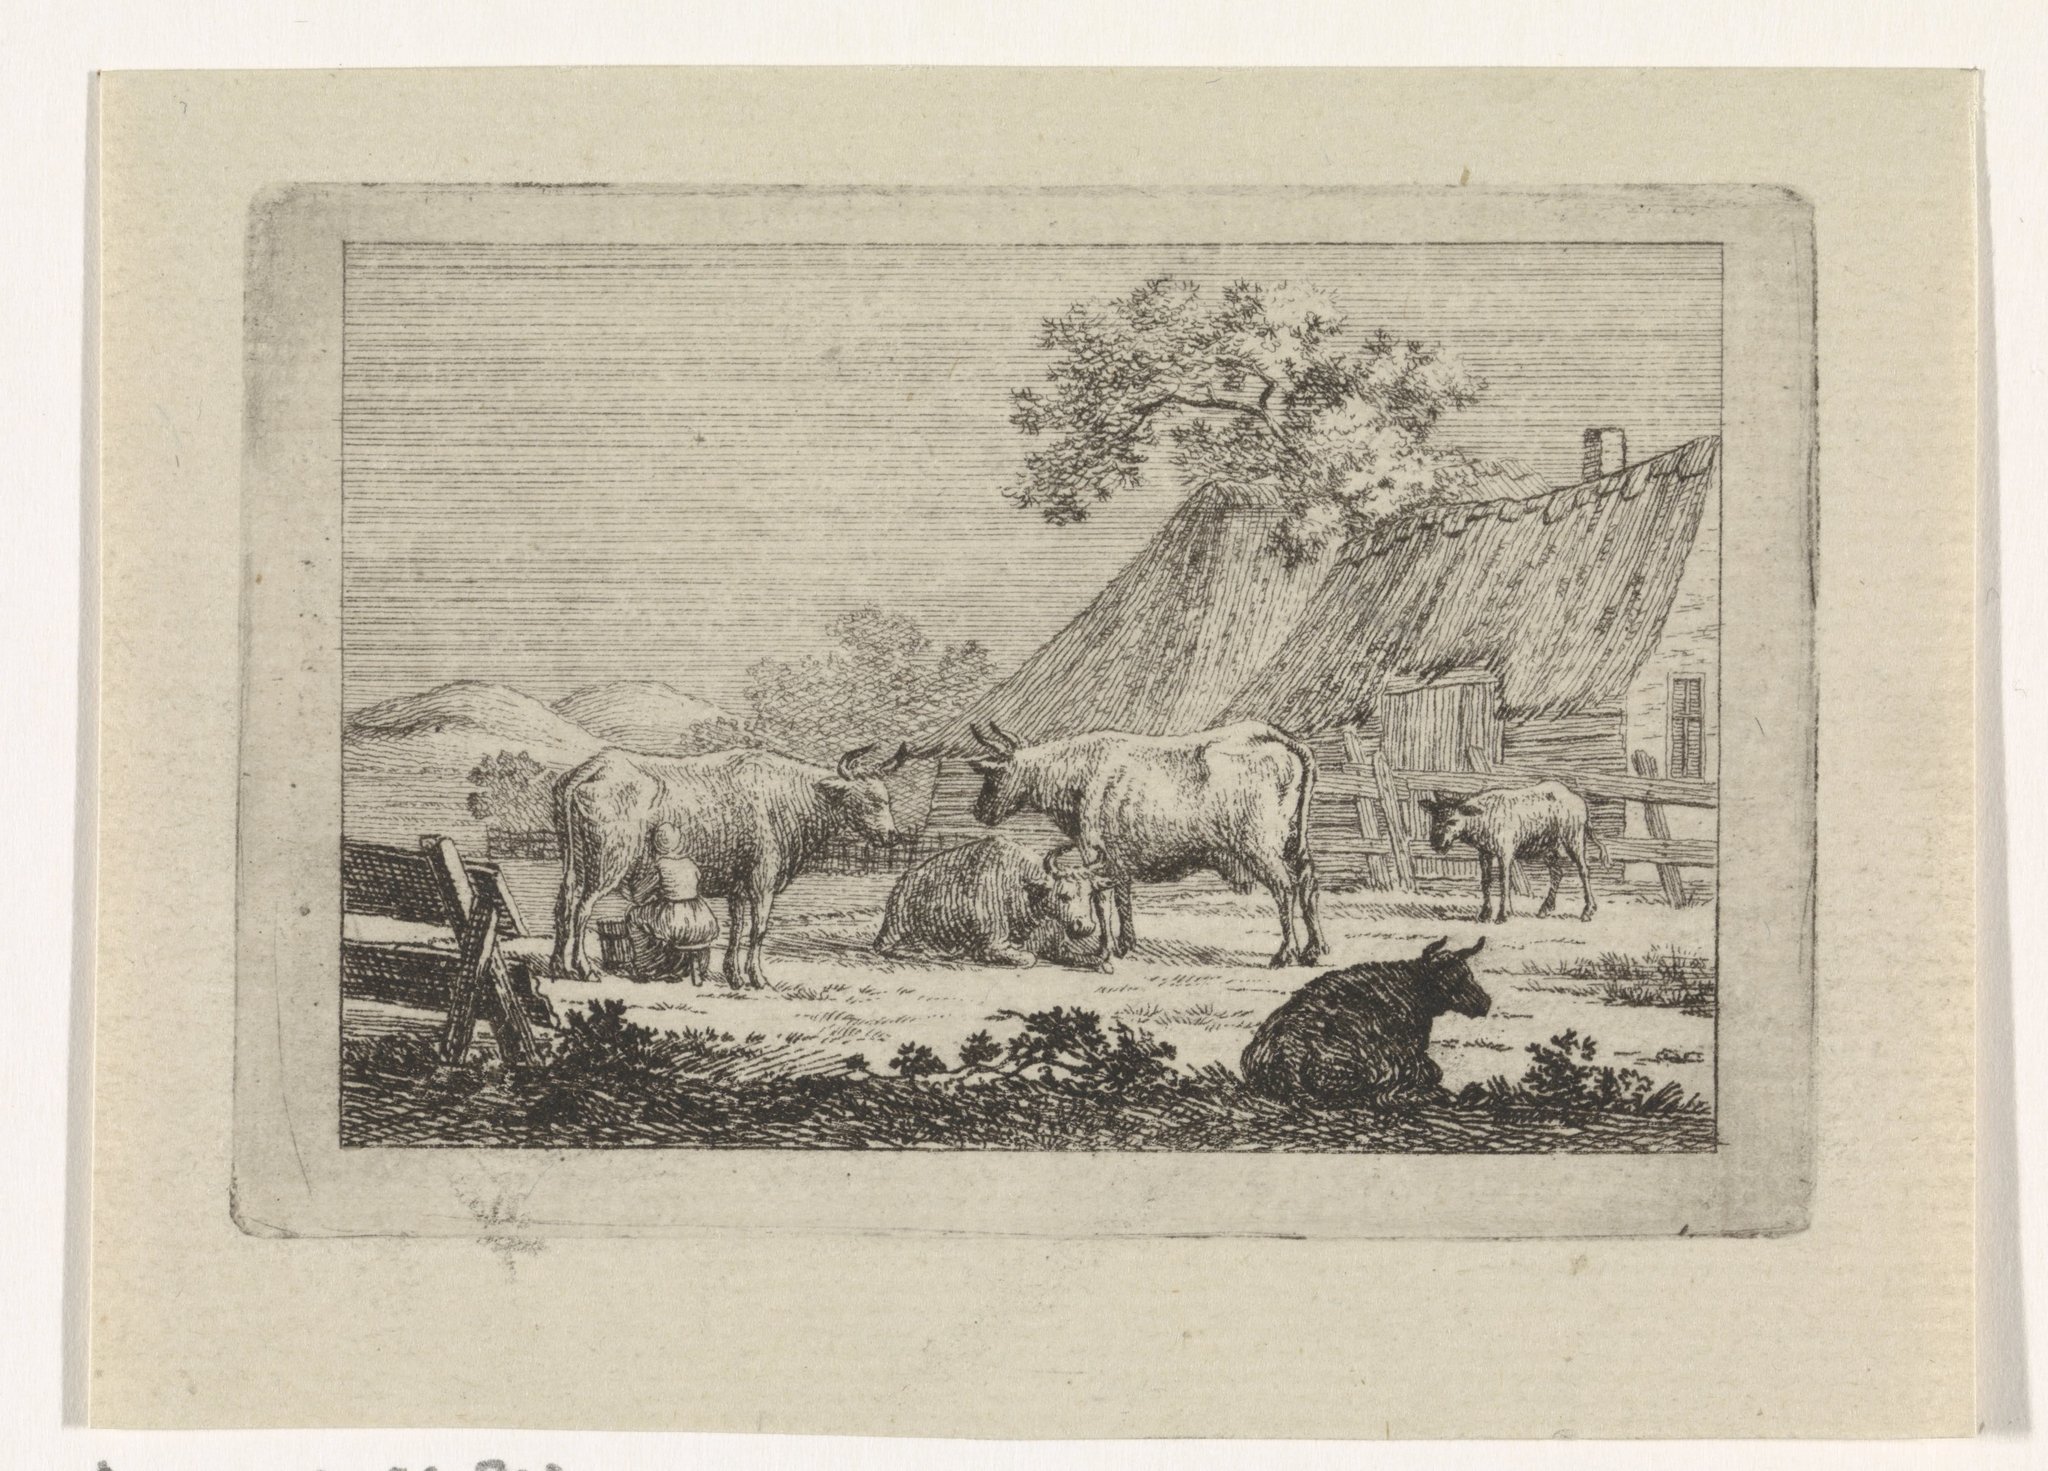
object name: print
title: Boerenerf met koeien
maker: pieter de goeje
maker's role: draughtsman, print maker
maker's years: 1789-1859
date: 1812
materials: paper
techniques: etching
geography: amsterdam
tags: cow, farmers - aa - female farmer, farmer's wife, farm (building), milking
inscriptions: collector's mark: Lugt 2228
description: Een weide met vier koeien en een kalf. Een van de koeien wordt door een boerin gemolken. Op de achtergrond de boerderij.